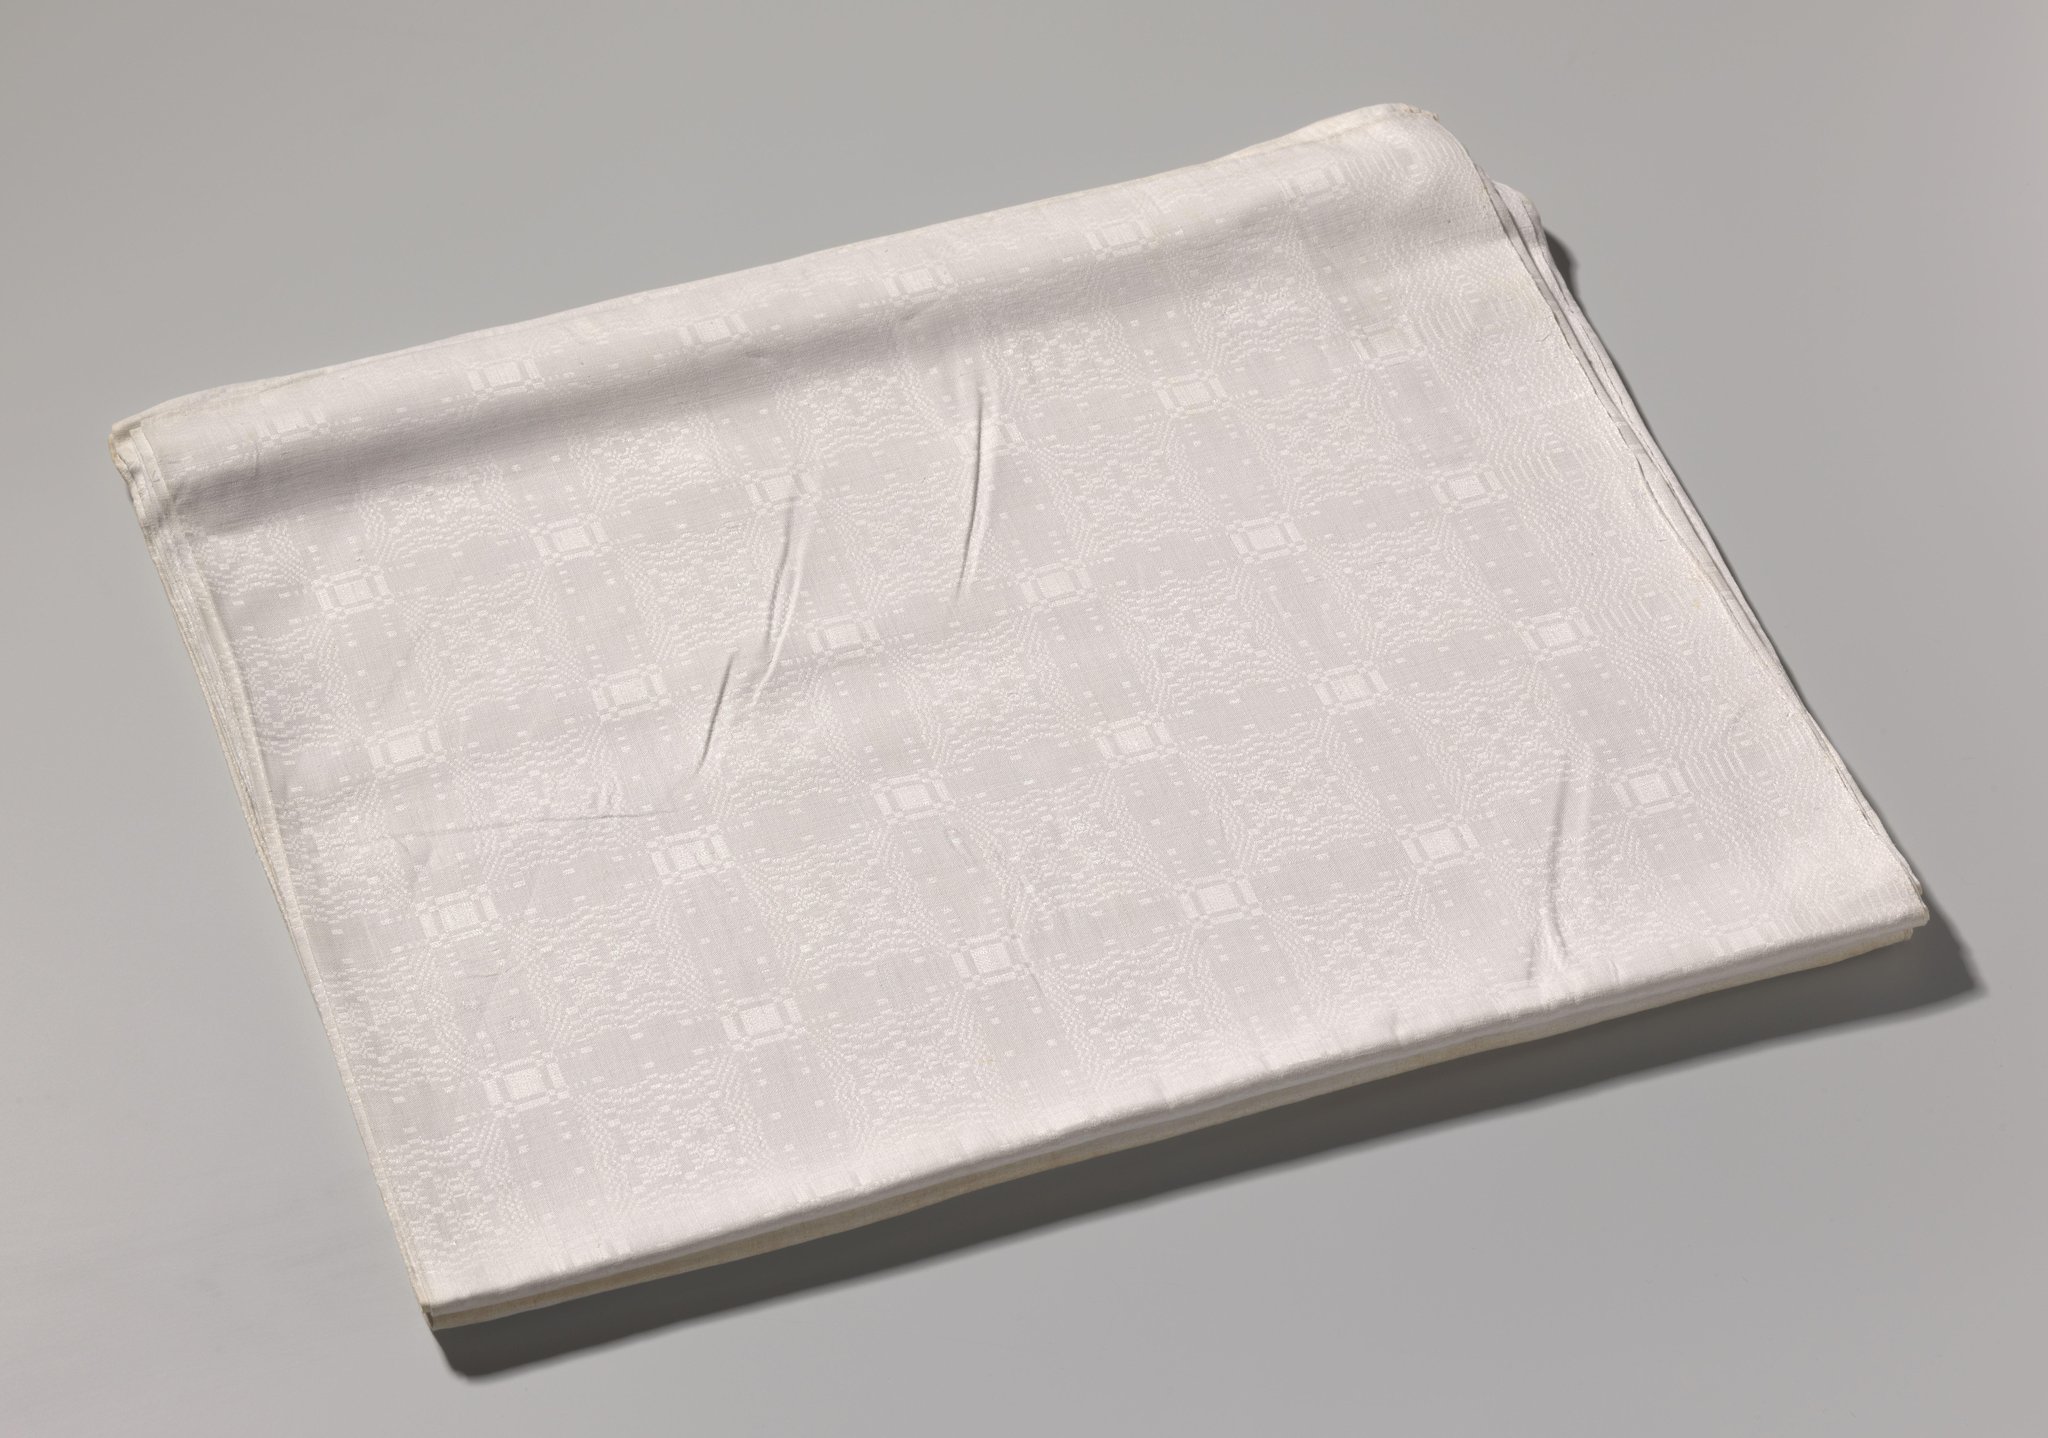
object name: tablecloth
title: Pellen. Merk: kroon IS6.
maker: Anonymous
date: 1692-1735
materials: linen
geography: northern netherlands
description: Tafellaken met pellen patroon, merk kroon IS en 6